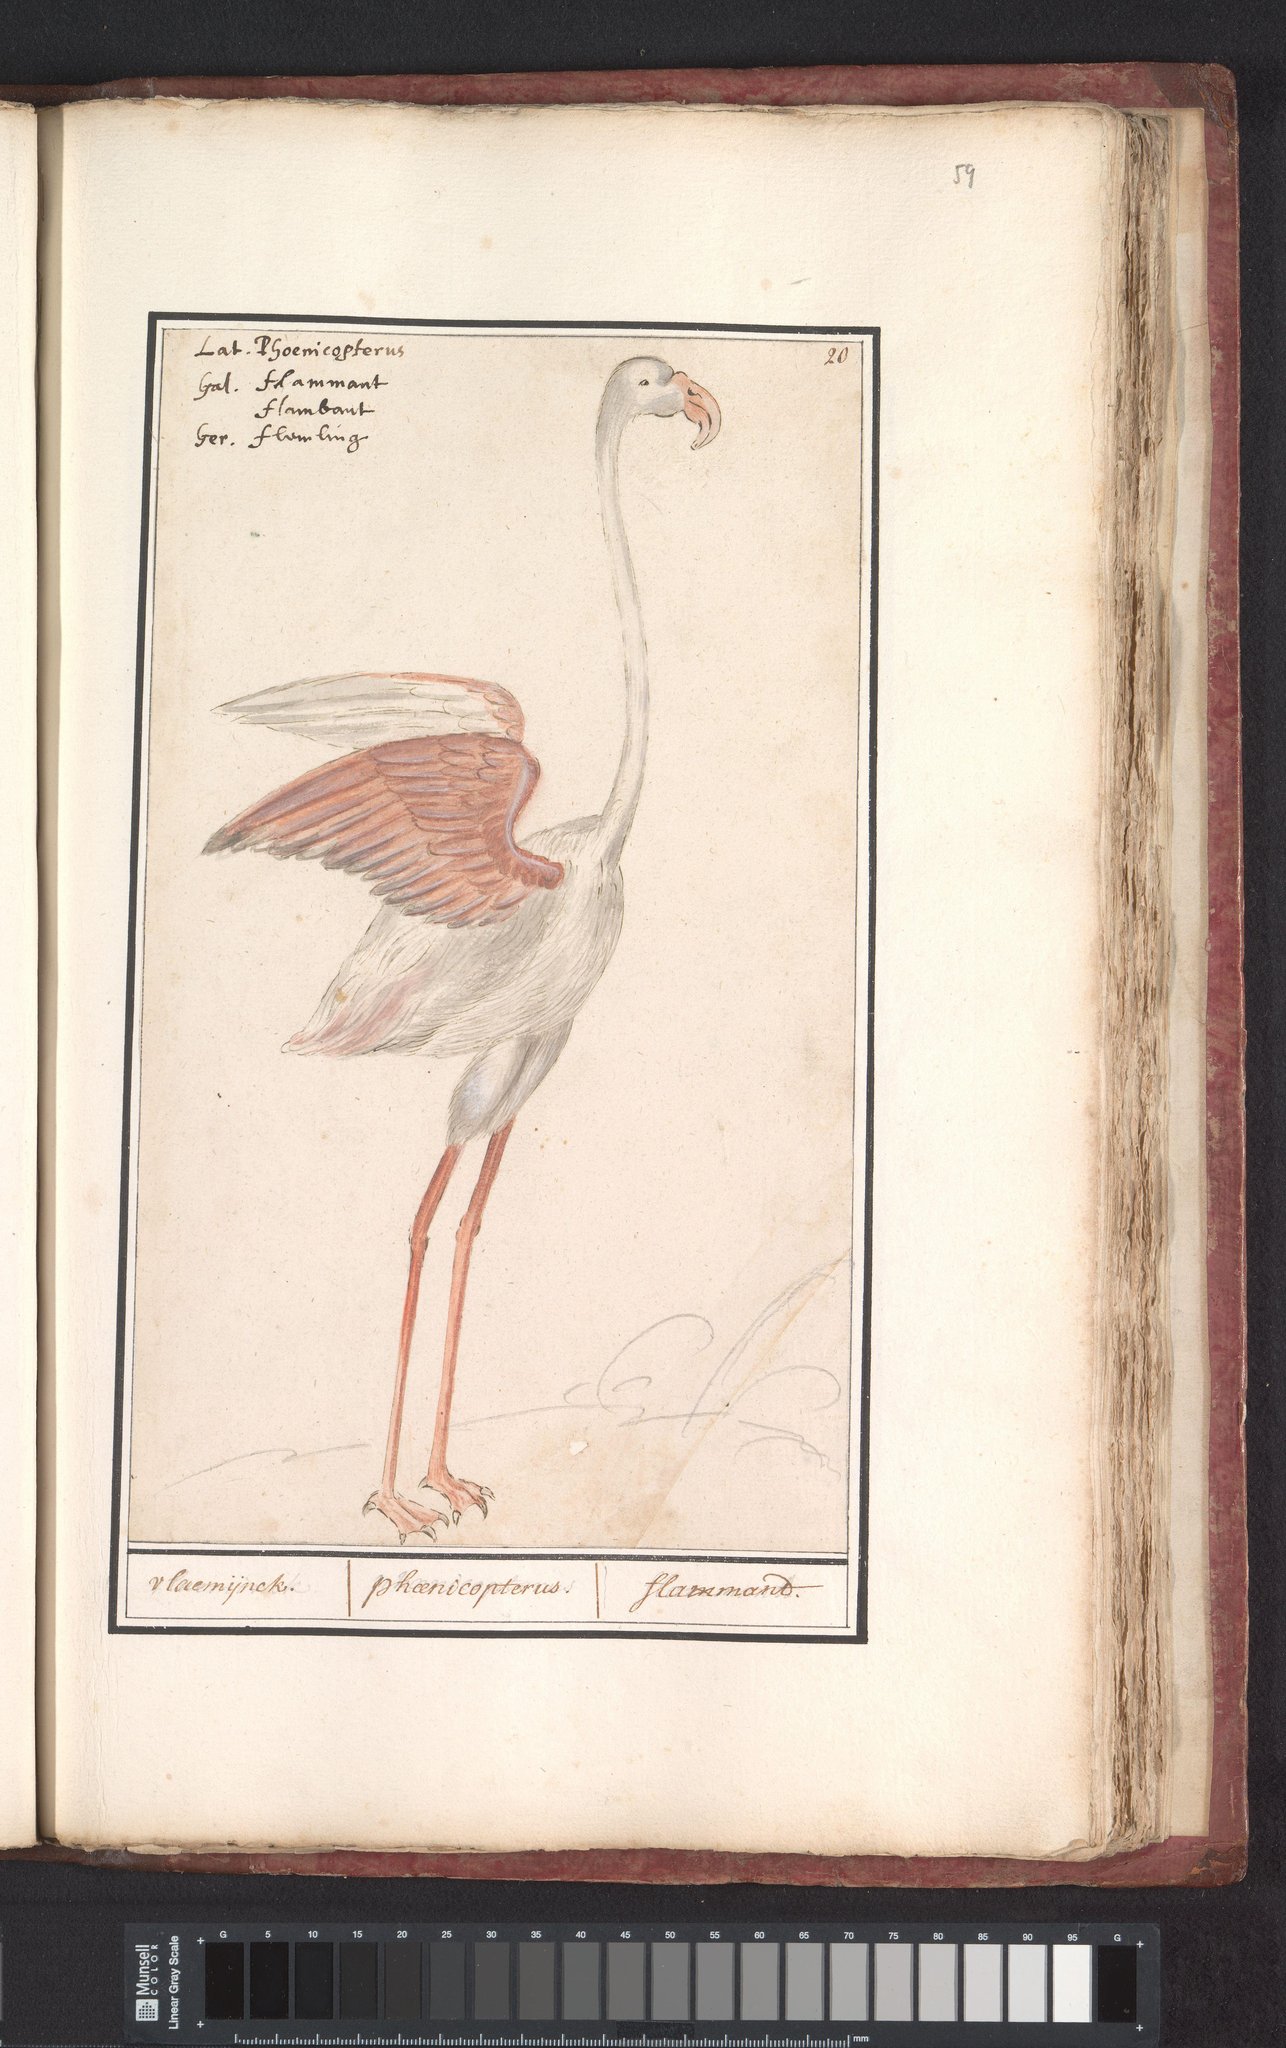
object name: drawing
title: Greater Flamingo (Phoenicopterus roseus)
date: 1596-1610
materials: chalk, paint, ink, paper, pencil, watercolor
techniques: brush, pen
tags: shore-birds and wading-birds: flamingo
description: When the Bruges mayor Joseph van Huerne rebound the albums from the Historia Naturalis in the early 18th century, he had the drawings mounted on folios with ruled borders, with the name of each creature written in the Dutch, Latin and French forms of the time. He also added the suggestion of a setting by adding some small strokes in black chalk on the sheet.